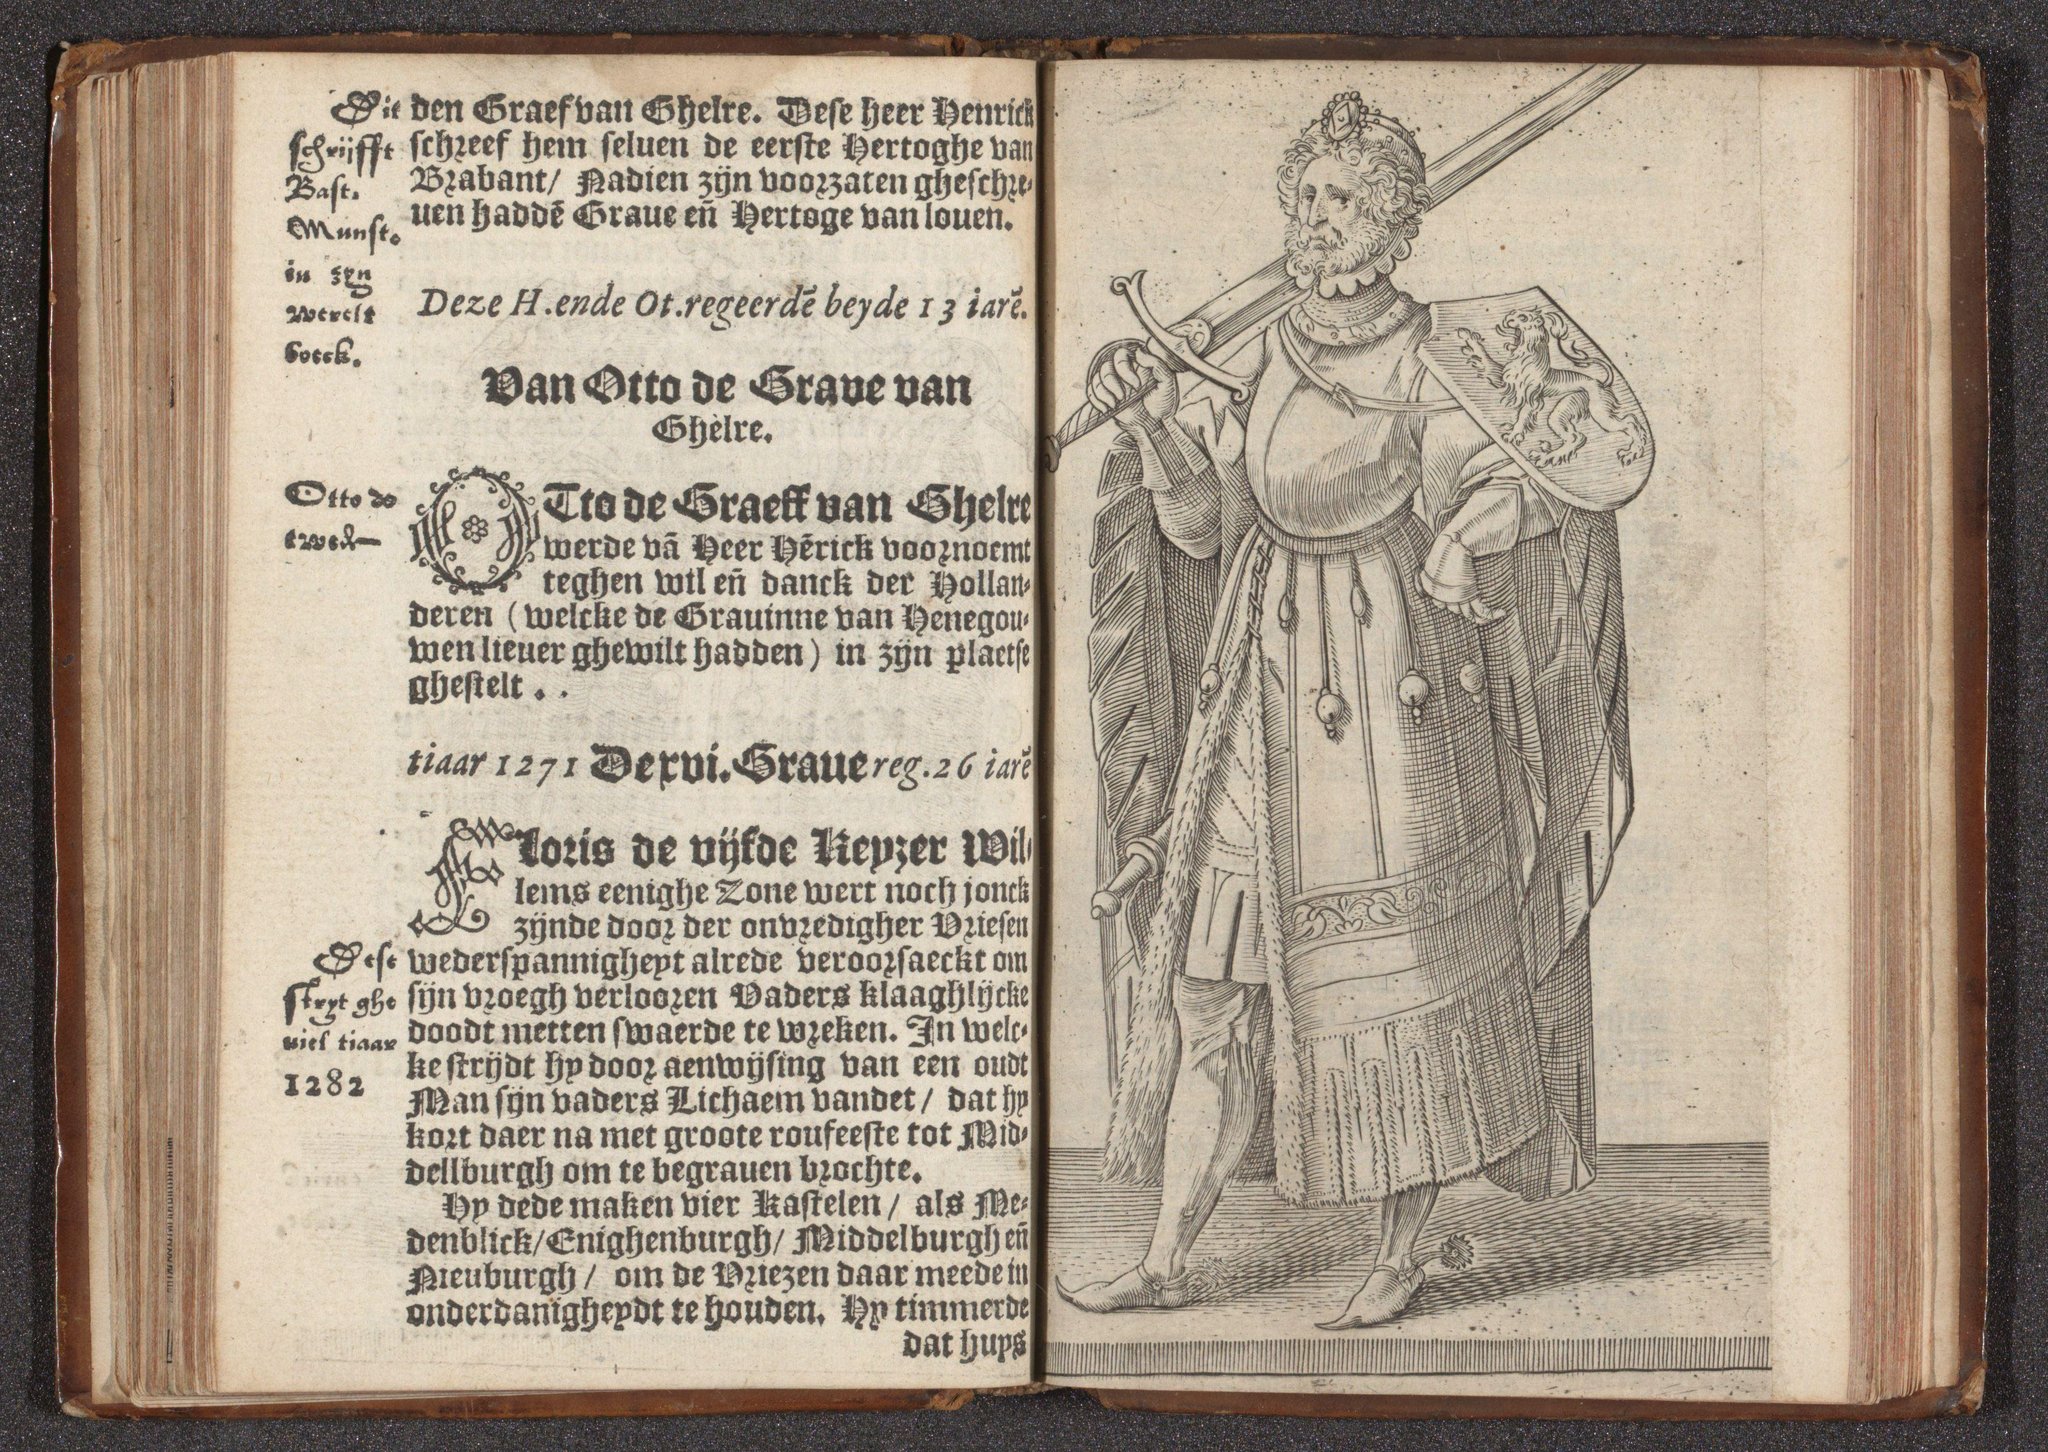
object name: print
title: Graaf Floris V van Holland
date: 1586-1587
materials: paper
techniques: engraving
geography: haarlem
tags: leiden, floris v (graaf van holland en zeeland), historical persons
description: Graaf Floris V van Holland, ten voeten uit, met zwaard op zijn schouder. Op het wapenschild een klimmende leeuw. De prent maakt deel uit van een boek met beschrijvingen en voorstellingen van de graven van Holland, Zeeland en Friesland.